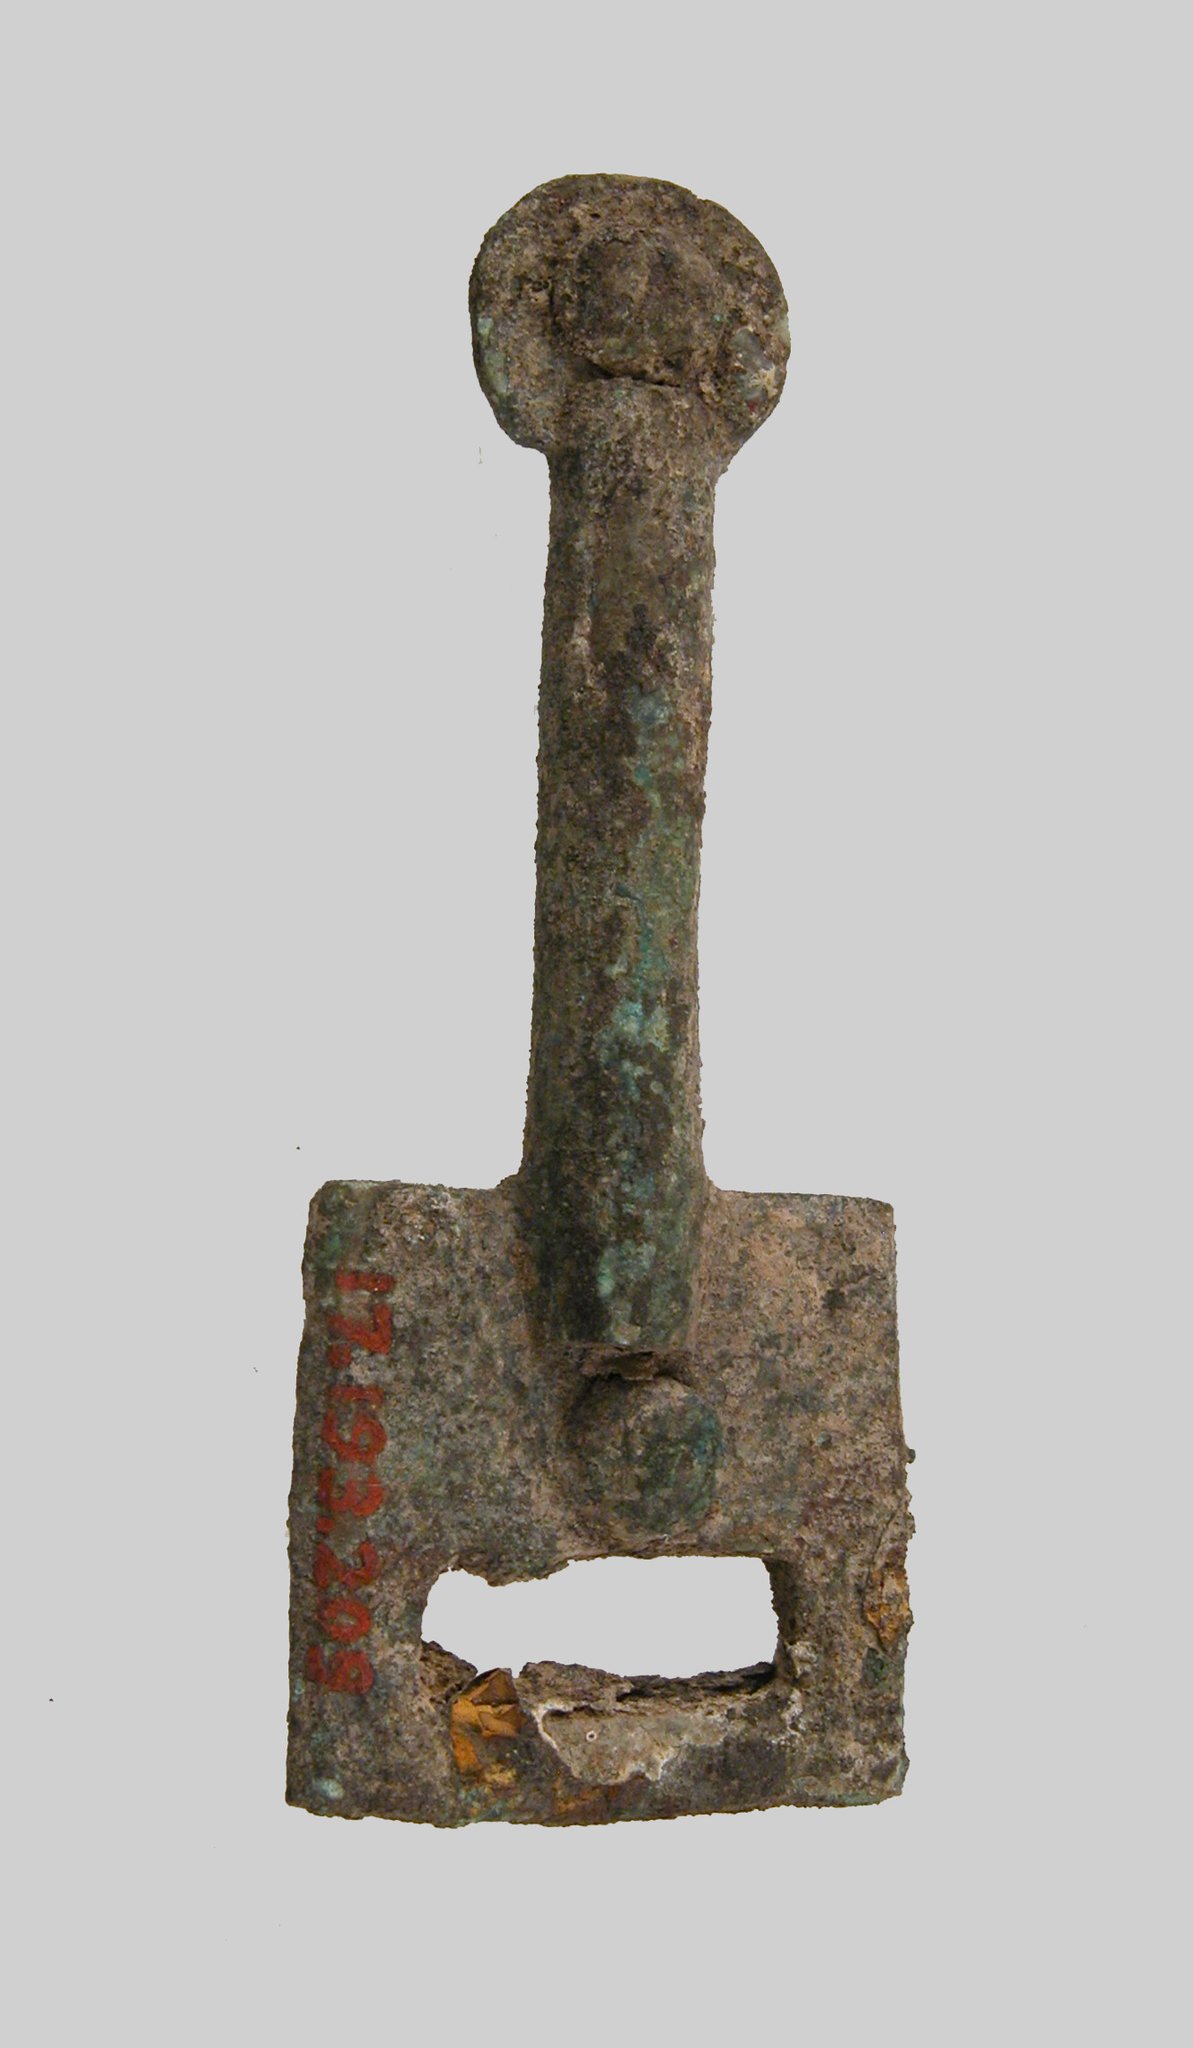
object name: plaque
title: Rectangular Plaque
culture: frankish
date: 534-566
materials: copper alloy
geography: rhein